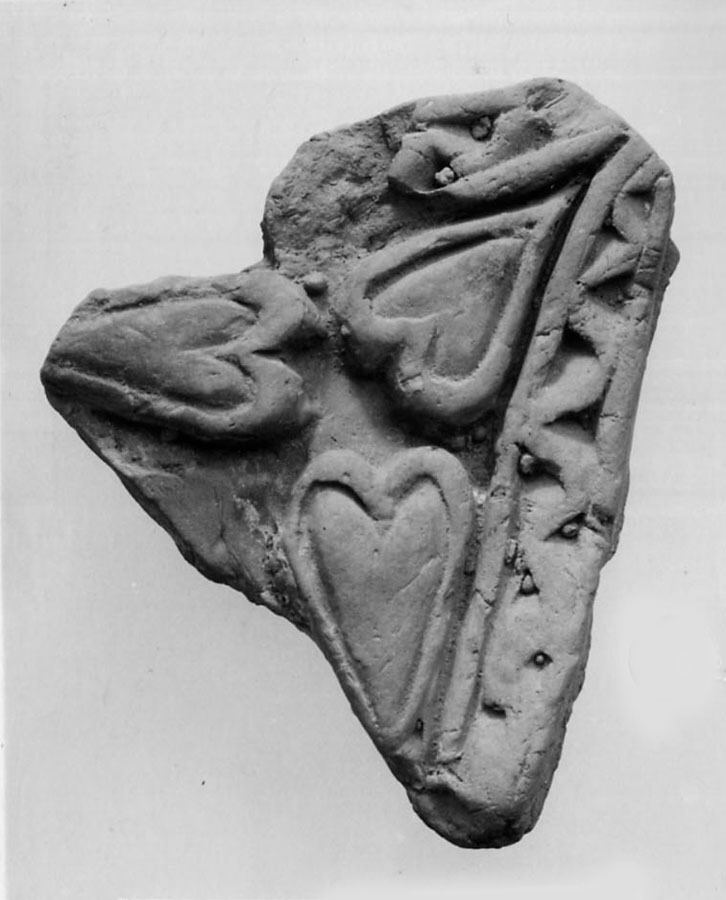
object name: ornament fragment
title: Fragment of an Ornament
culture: central asian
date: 1101-1133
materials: clay